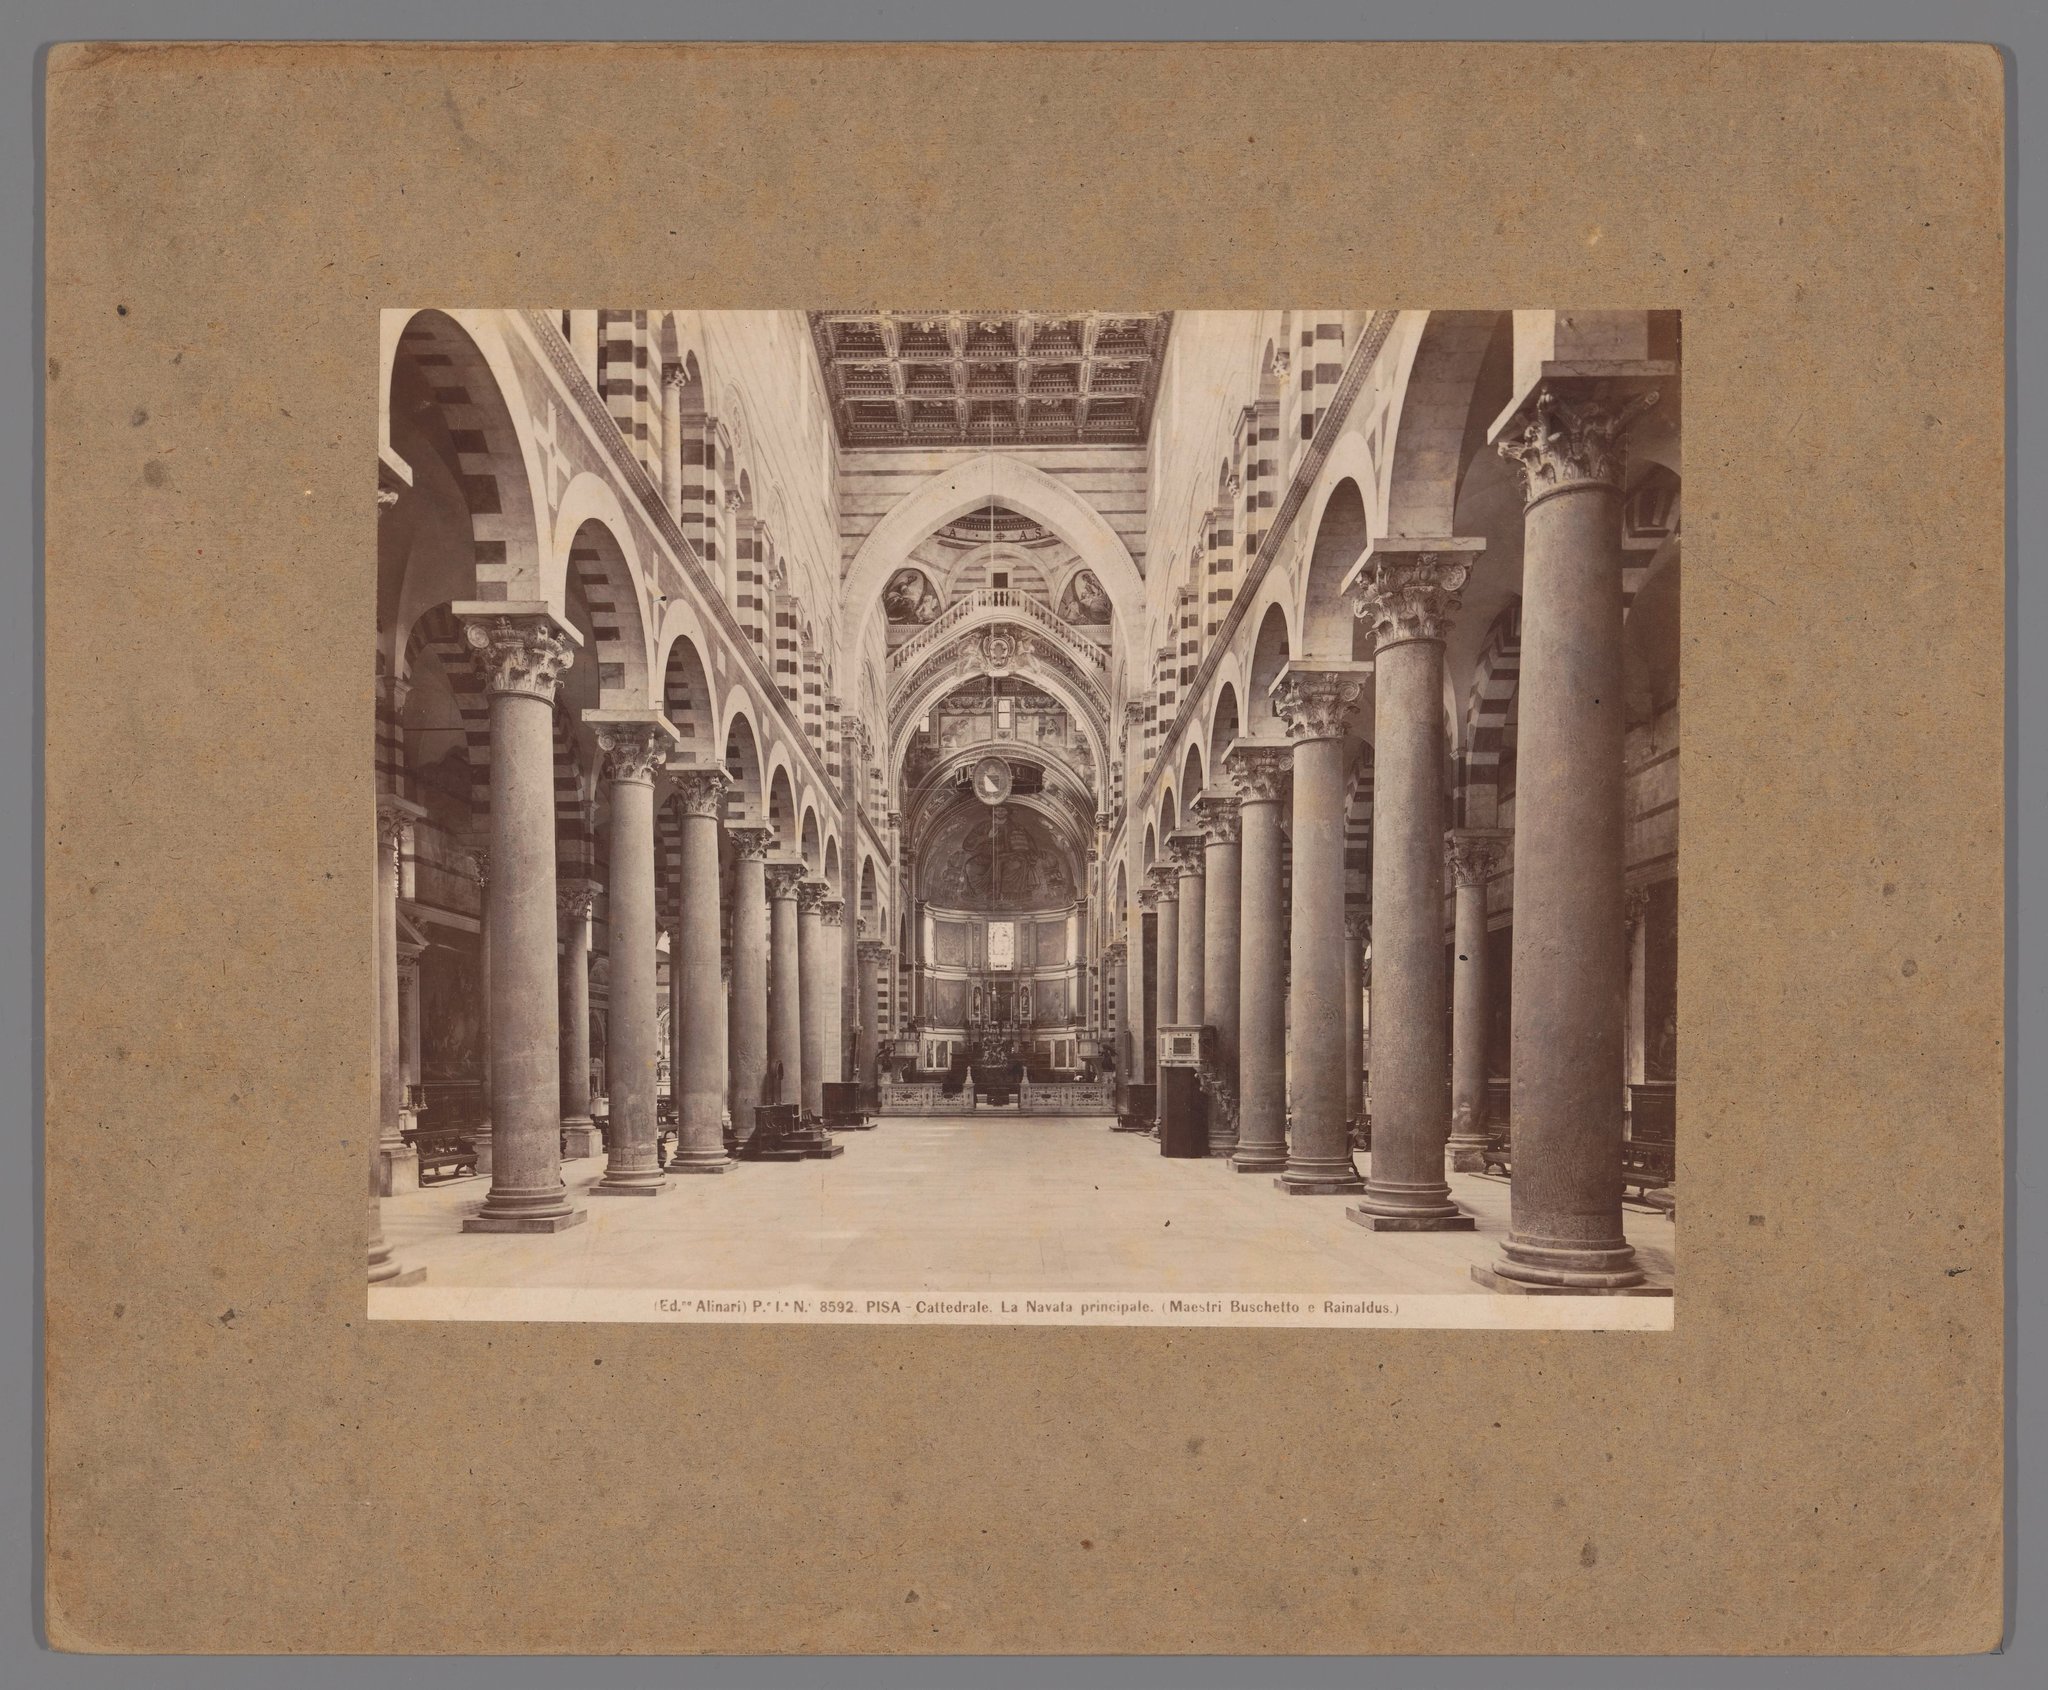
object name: photograph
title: Interieur van de Dom van Pisa, met zicht op het koor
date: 1875-1900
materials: cardboard, photographic support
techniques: albumen print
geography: pisa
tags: parts of church interior: nave, parts of church interior: choir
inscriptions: number: ‘P.e I.a N.o 8592.’, collector's mark: Lugt 3937